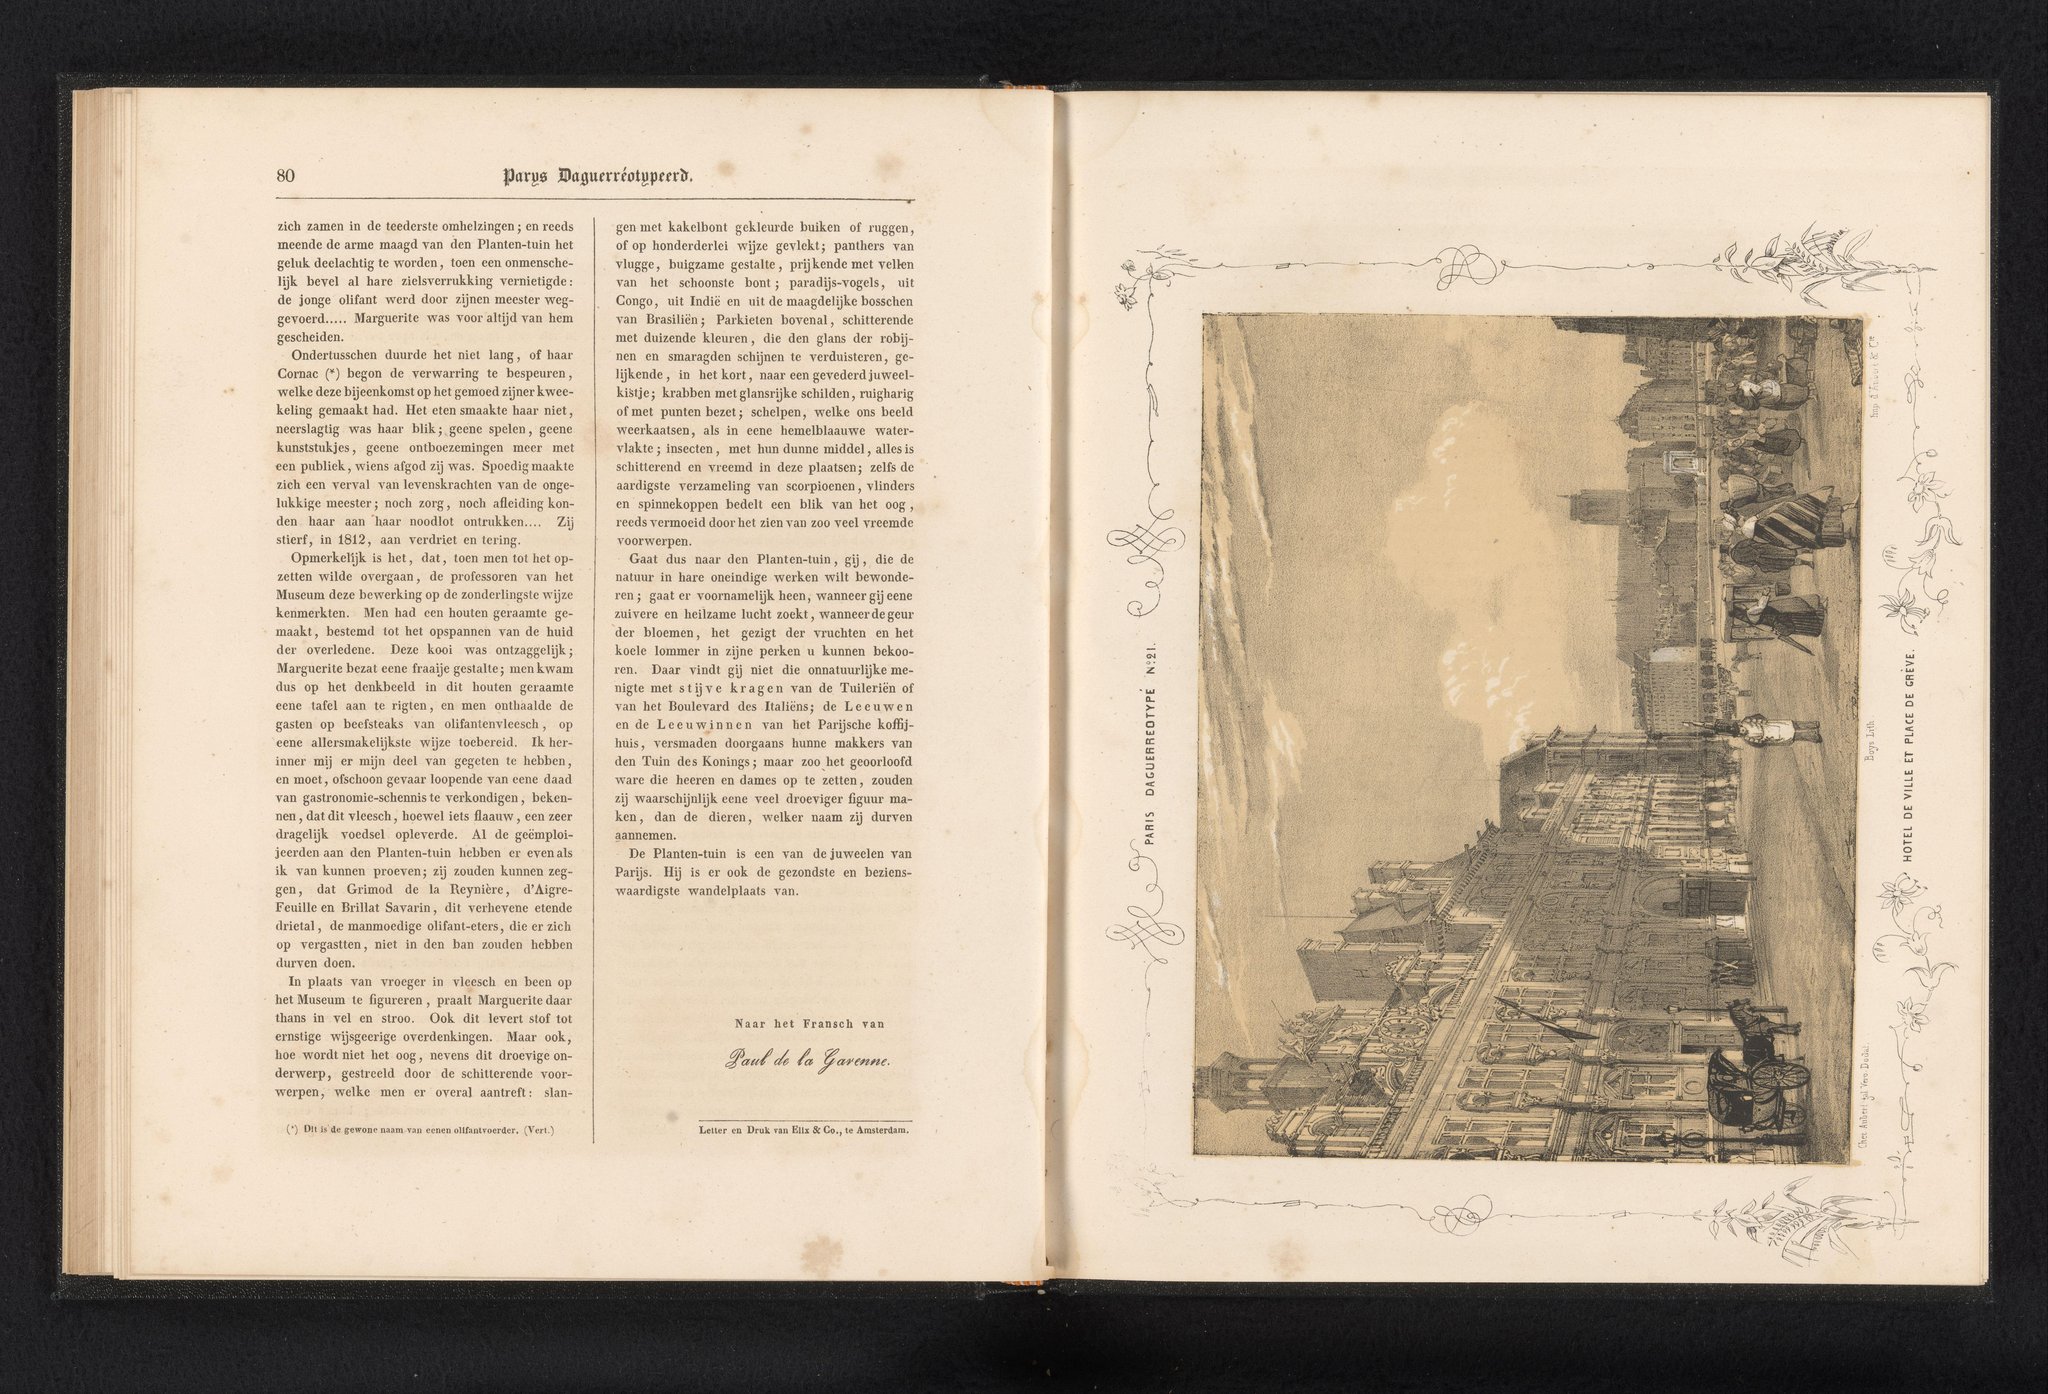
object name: page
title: Stadhuis van Parijs aan het Place de Grève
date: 1839-1840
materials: paper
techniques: tone lithography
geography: paris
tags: townhall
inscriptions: inscription: ‘PARIS DAGUERRÉOTYPÉ No. 21.’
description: Prent op drieëntachtigste ongenummerde pagina.